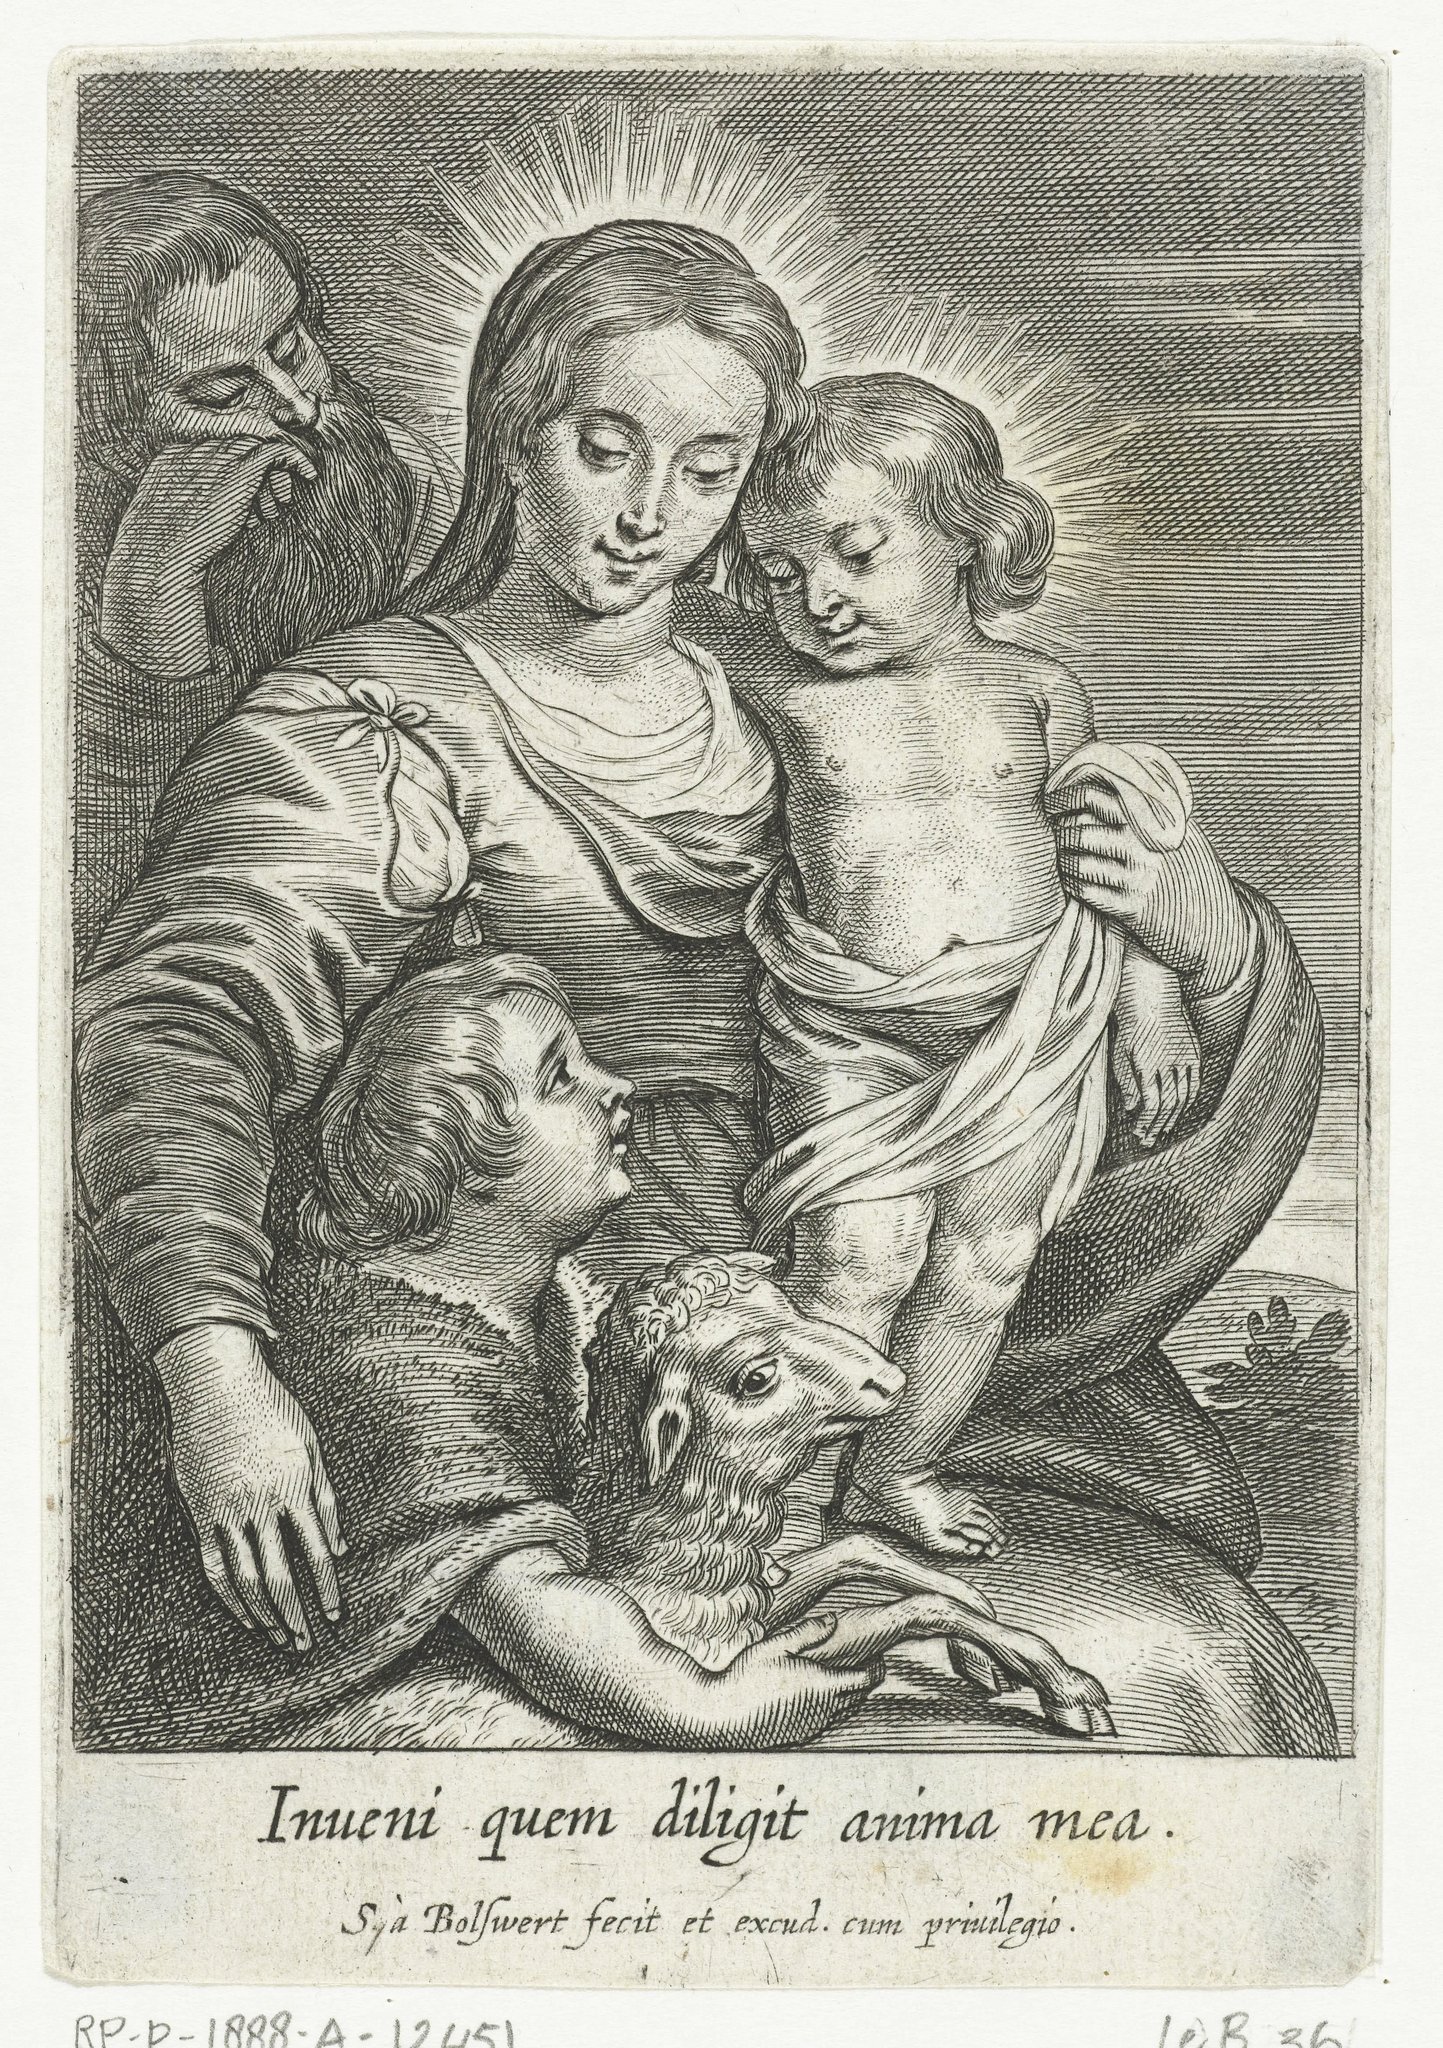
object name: print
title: Vélins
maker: schelte adamsz. bolswert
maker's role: print maker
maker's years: 1586-1659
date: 1596-1659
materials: paper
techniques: engraving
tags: mary and the christ-child with john the baptist (as child)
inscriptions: collector's mark: Lugt 2228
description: Prent uit serie Vélins met negentig prenten naar ontwerp van Peter Paul Rubens. In de bronnen vinden we uiteenlopende gegevens over aantal en samenstelling van de serie. Hollstein hanteert het aantal van negentig prenten. De reeks Vélins in de collectie van het RMA bevat verschillende staten afkomstig uit meerdere uitgaven welke moeilijk te duiden zijn. Sommige dragen het originele adres van Schelte Adamsz. Bolswert als graveur en uitgever, op andere exemplaren is deze naam verwijderd (duidelijk zichtbaar!) en vervangen door de naam Cornelis Galle (II). De prenten met de naam van uitgever Galle zijn vaak opgewerkt. We treffen nog een andere naam van een uitgever bij enkele prent aan: Martien van den Enden. Herkomst uit meerdere uitgaven spreekt ook uit afwijkende opschriften in Nederlands en Latijn en variaties op dezelfde thema's welke misschien nooit langs elkaar in dezelfde serie gebruikt werden.